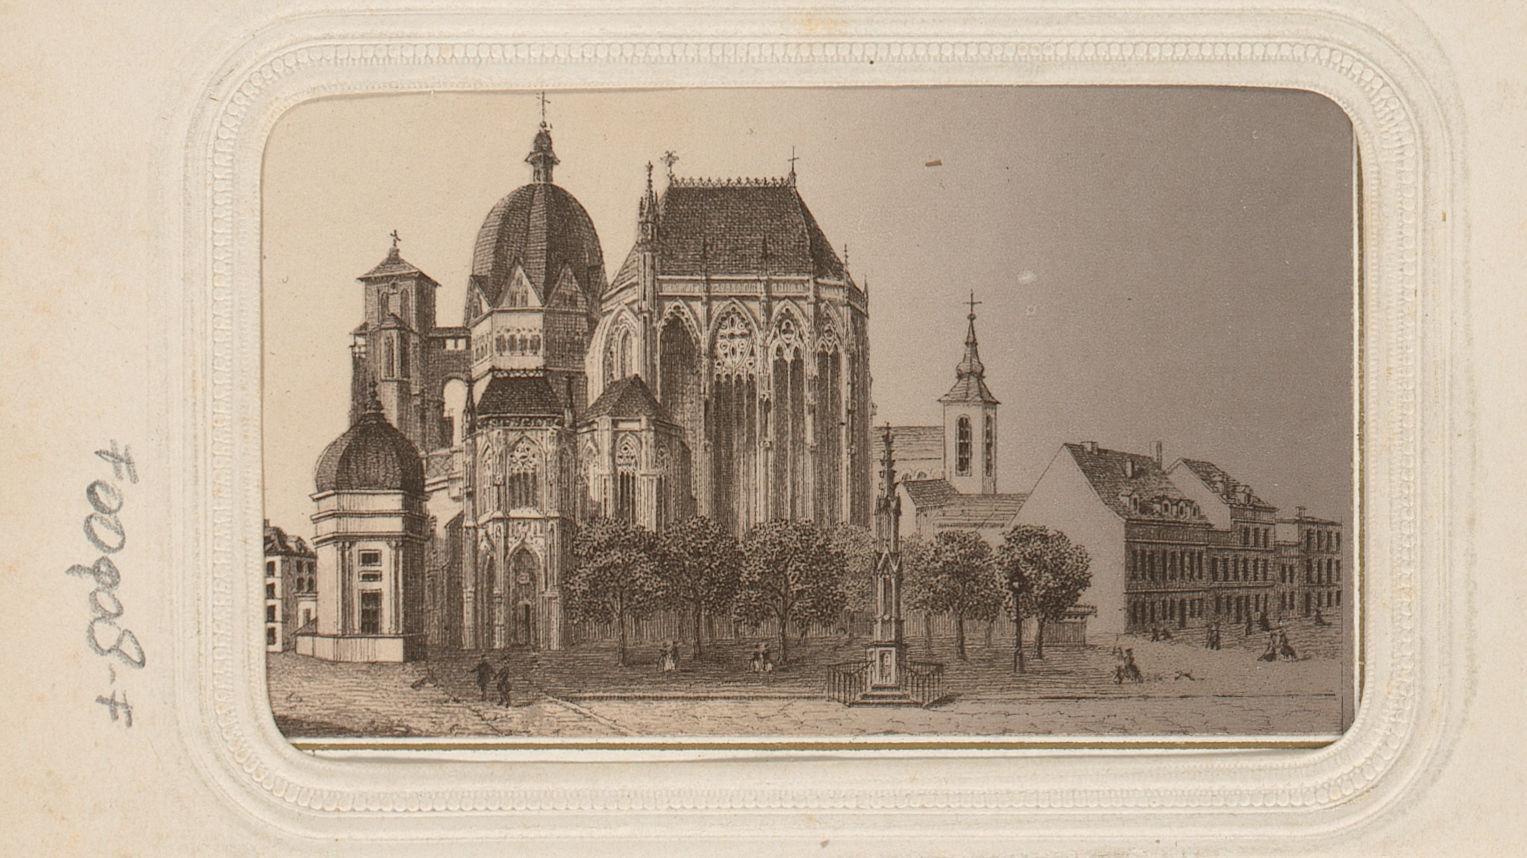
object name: reproduction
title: Aachen, Dom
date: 1860-1885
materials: cardboard, photographic support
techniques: collodion silver print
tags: dom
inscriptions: annotation: ‘Dom’, annotation: ‘Aken/ Dom’